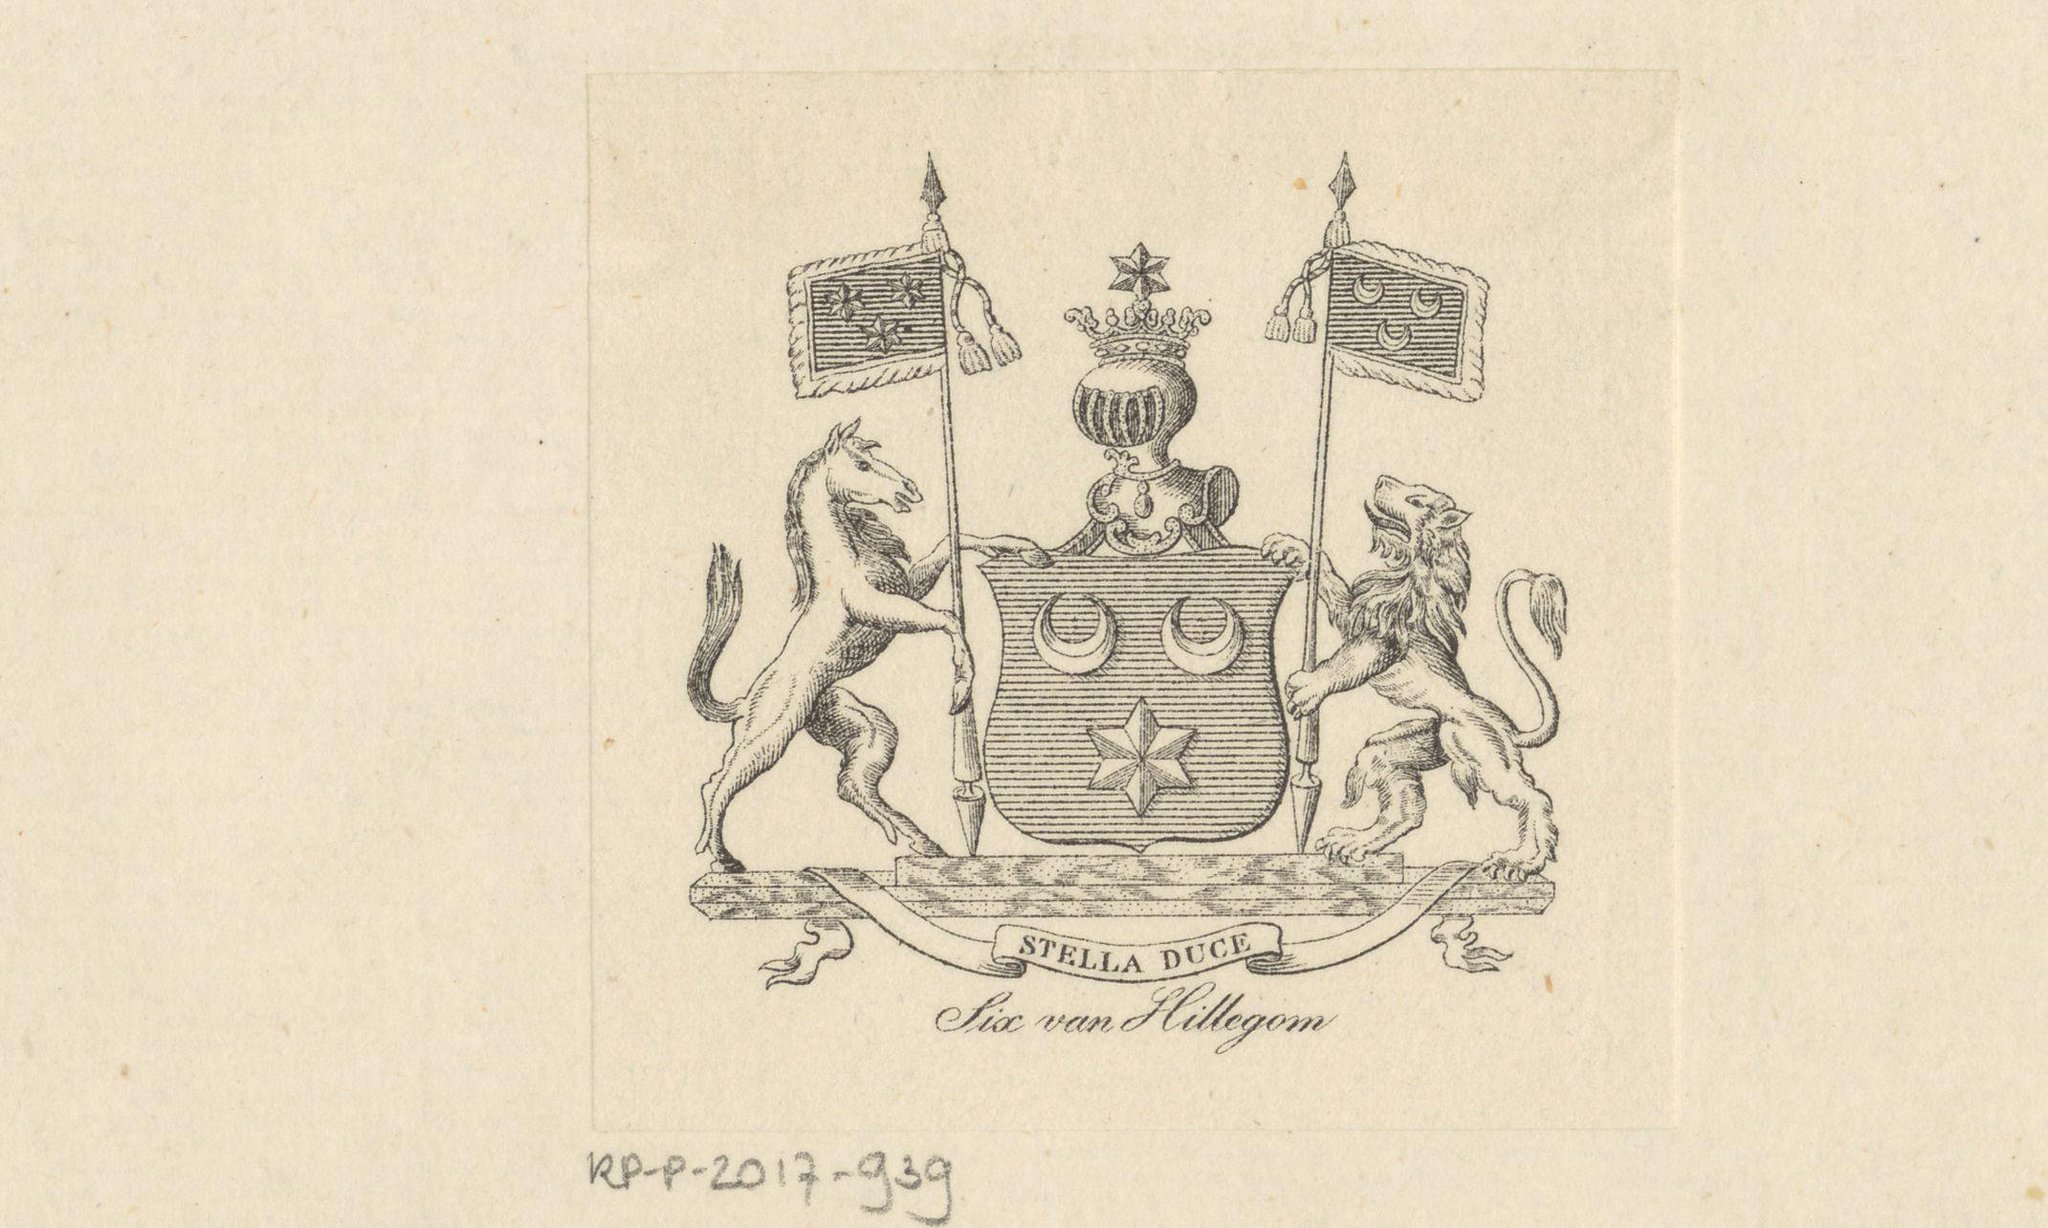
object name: bookplate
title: Ex libris van Six van Hillegom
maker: Anonymous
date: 1850-1901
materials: paper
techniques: printing block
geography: netherlands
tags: amsterdam, draughtsman, horse, beasts of prey, predatory animals: lion, armorial bearing, heraldry